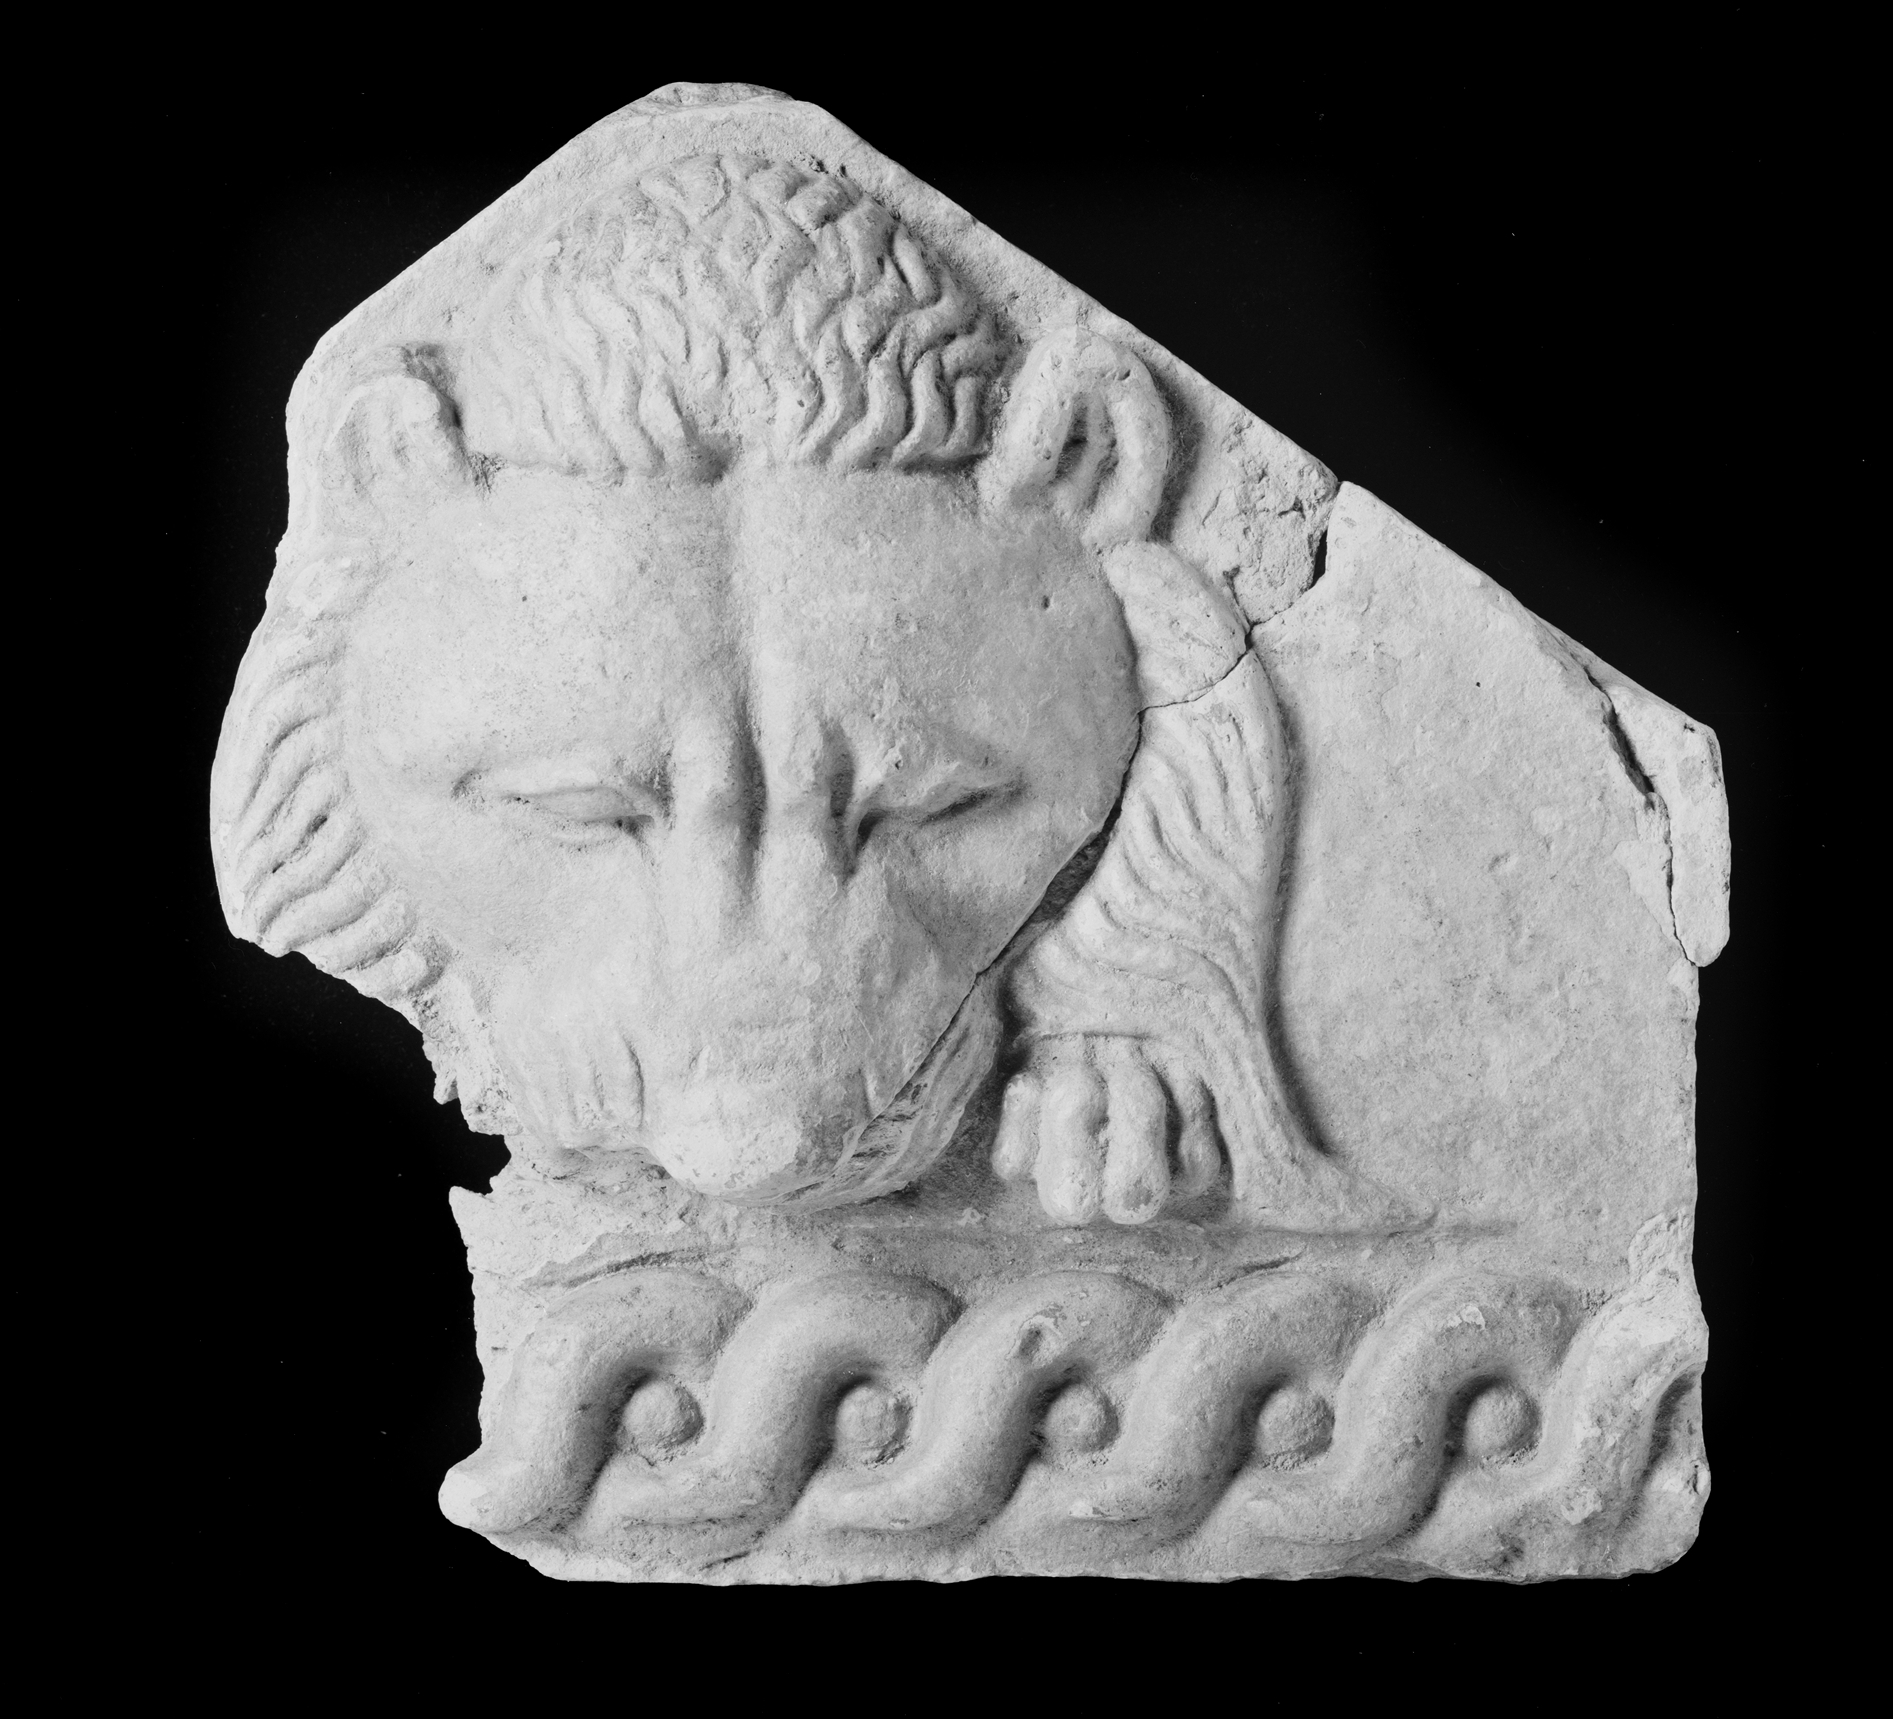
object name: antefix, lion mask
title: Terracotta antefix with lion's head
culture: east greek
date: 534-501 BCE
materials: terracotta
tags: lions